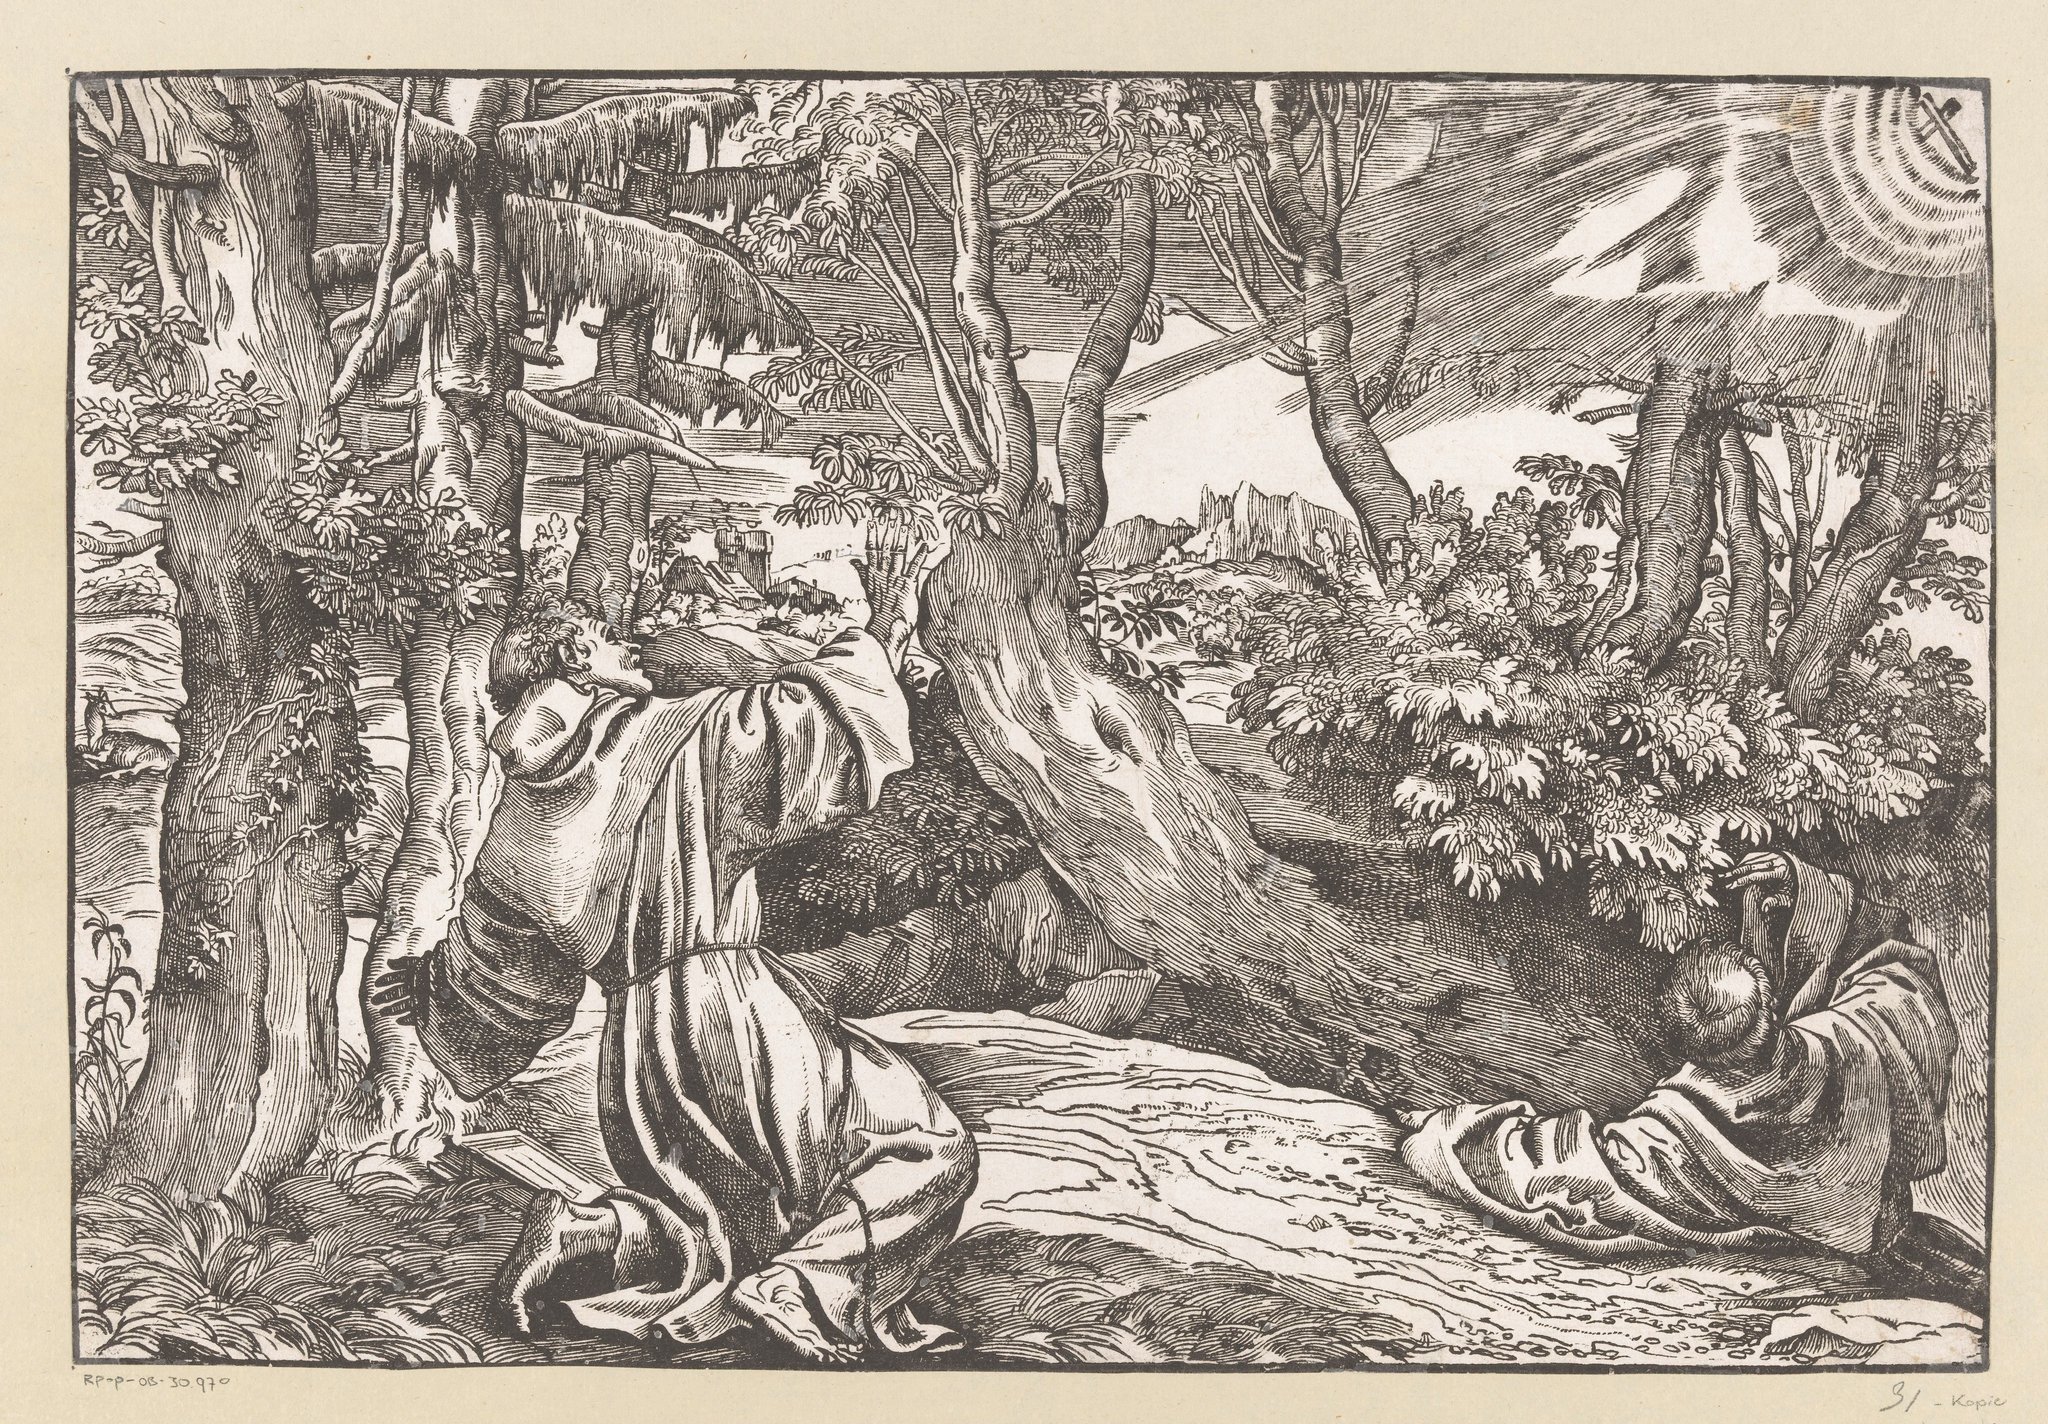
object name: print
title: Heilige Franciscus ontvangt de stigmata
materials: ink, paper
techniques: pen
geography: venice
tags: city-view, and landscape with man-made constructions, stigmatization of st. francis of assisi: in retreat on mount alverna, he beholds a vision of christ on the cross enveloped by wings (like a seraph with six wings); rays passing down to the body of the kneeling saint form the marks of the five wounds of christ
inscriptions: collector's mark: Lugt 240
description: De prent is rechtsboven beschadigd en met pen in zwart aangevuld. Op verscheidene plekken is de prent bewerkt met pen in grijs.